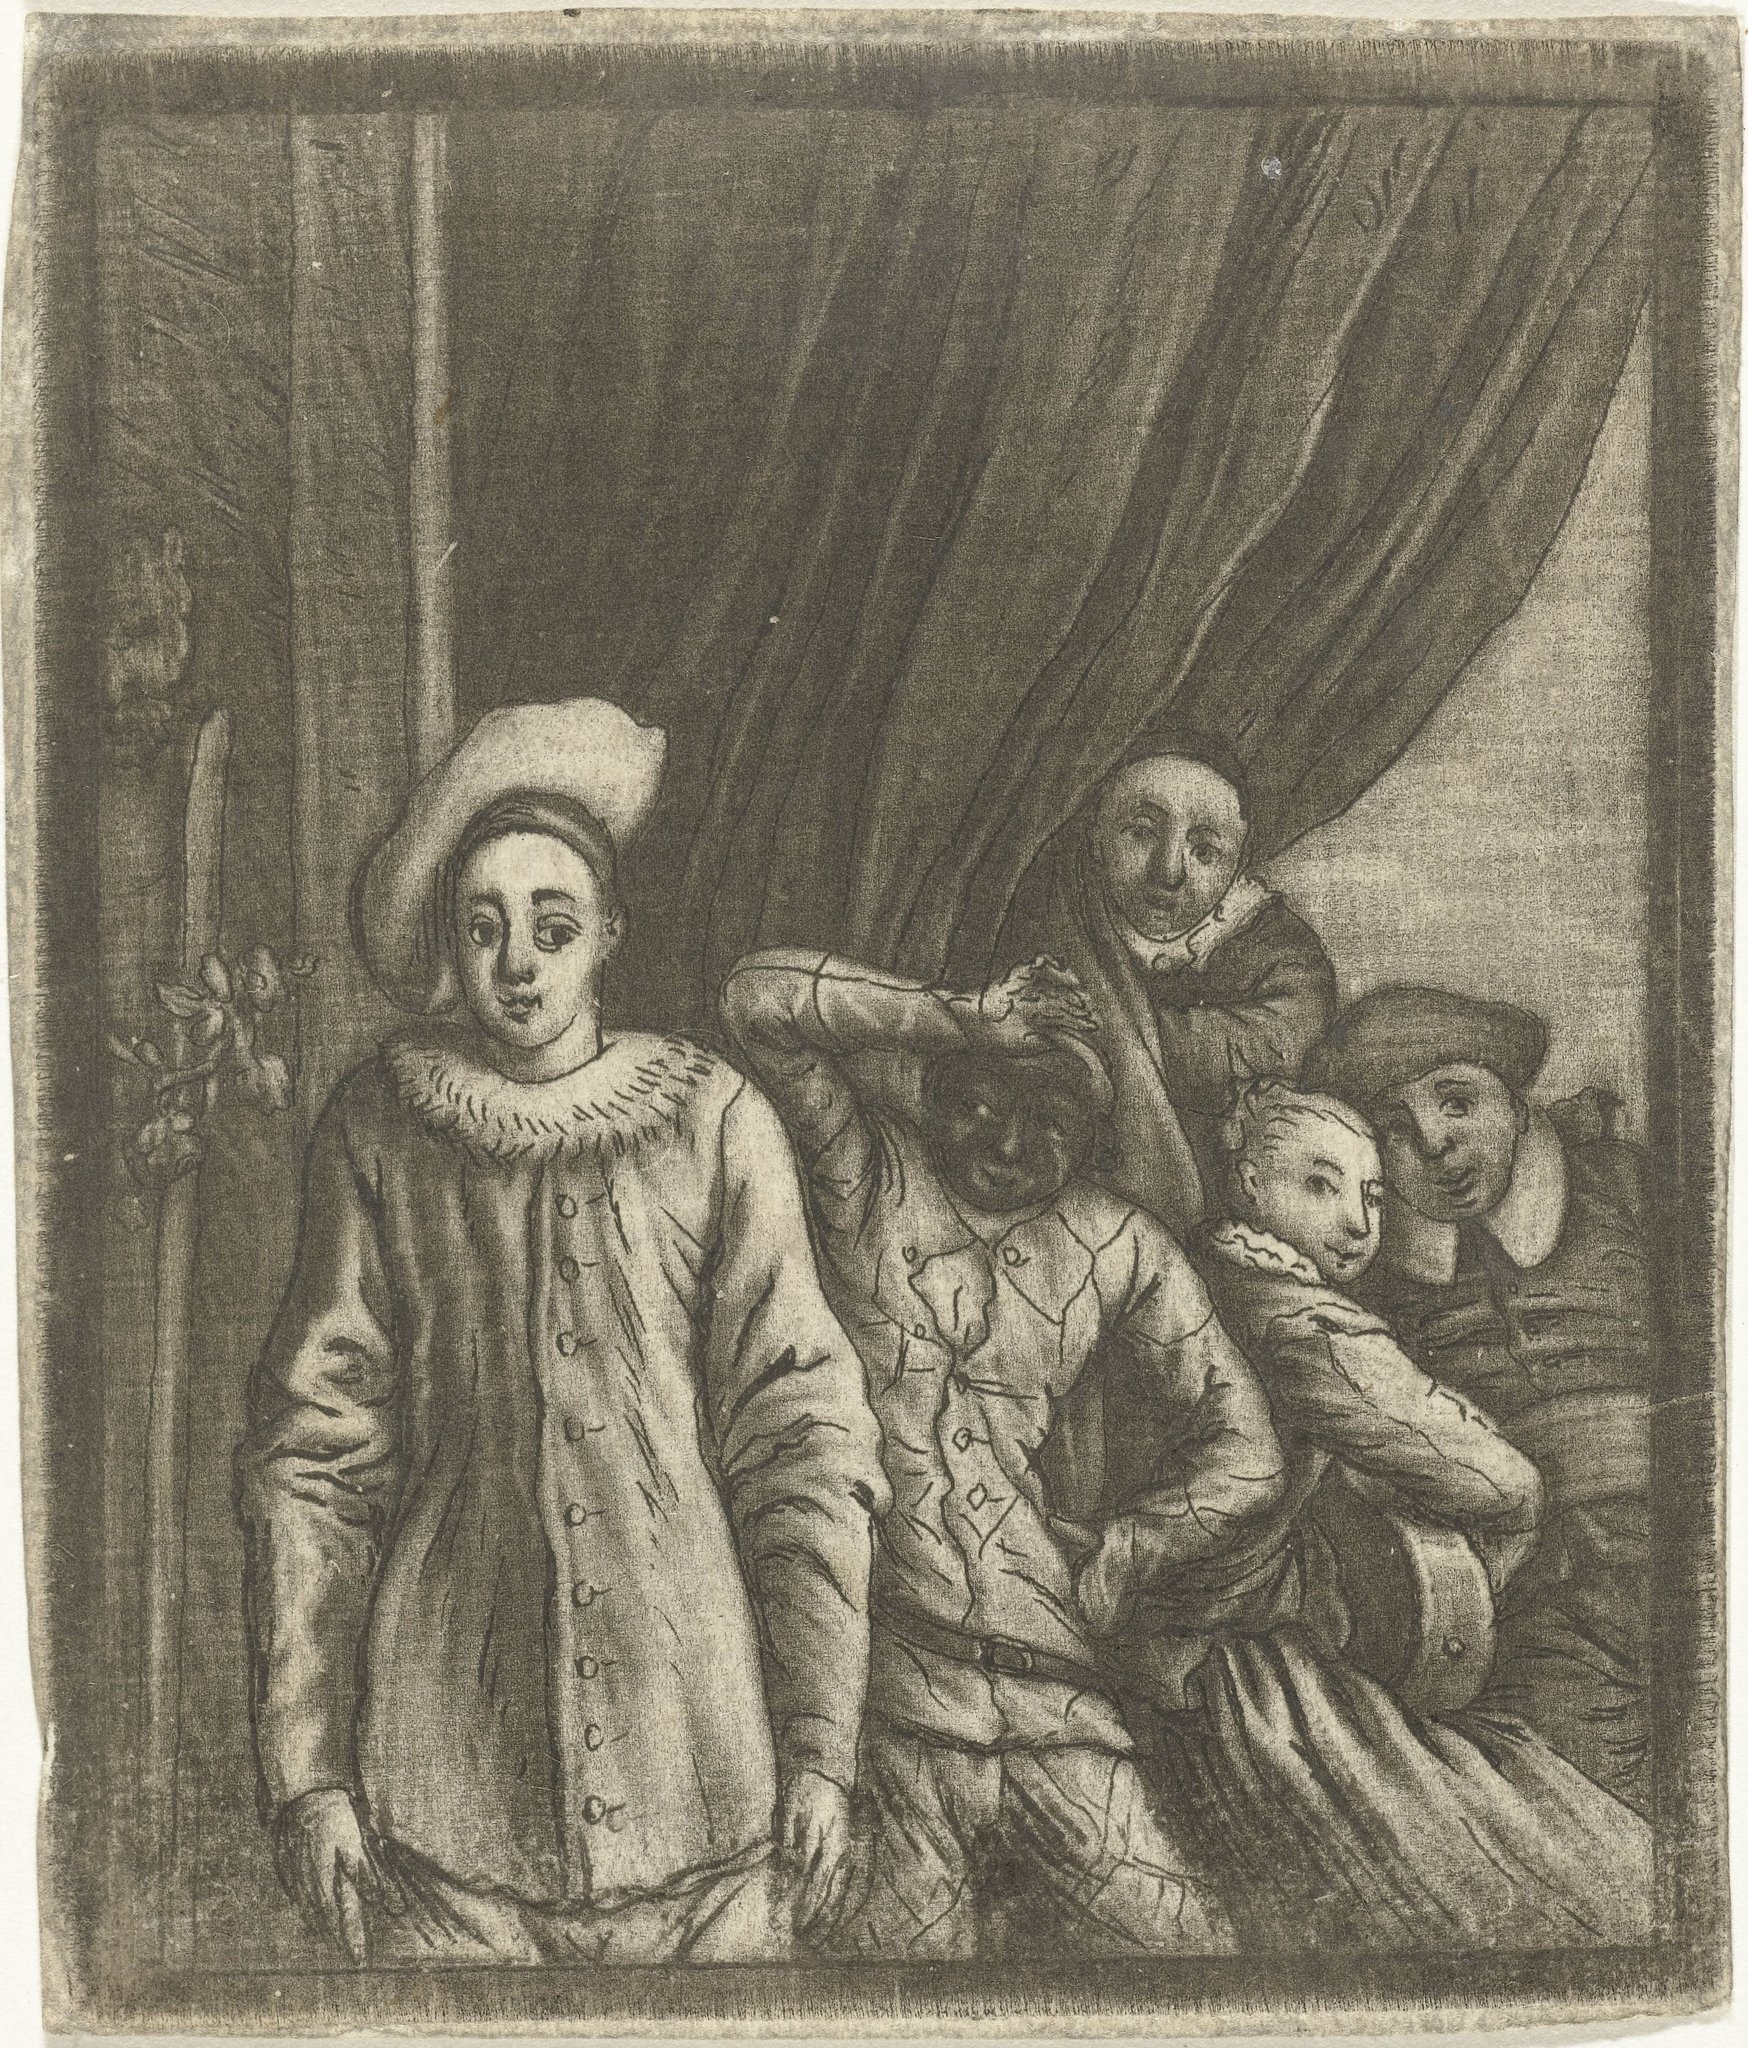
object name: print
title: Pierrot en Harlekijn, ca. 1700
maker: Anonymous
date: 1690-1800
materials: paper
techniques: etching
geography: netherlands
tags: 'commedia dell'arte'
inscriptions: collector's mark: Lugt 2228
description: Commedia dell'arte personages Pierrot en Harlekijn, op de achtergrond een groep personen waaronder een gitaarspeelster bij een gordijn, waarschijnlijk Colombina en Pantalone.